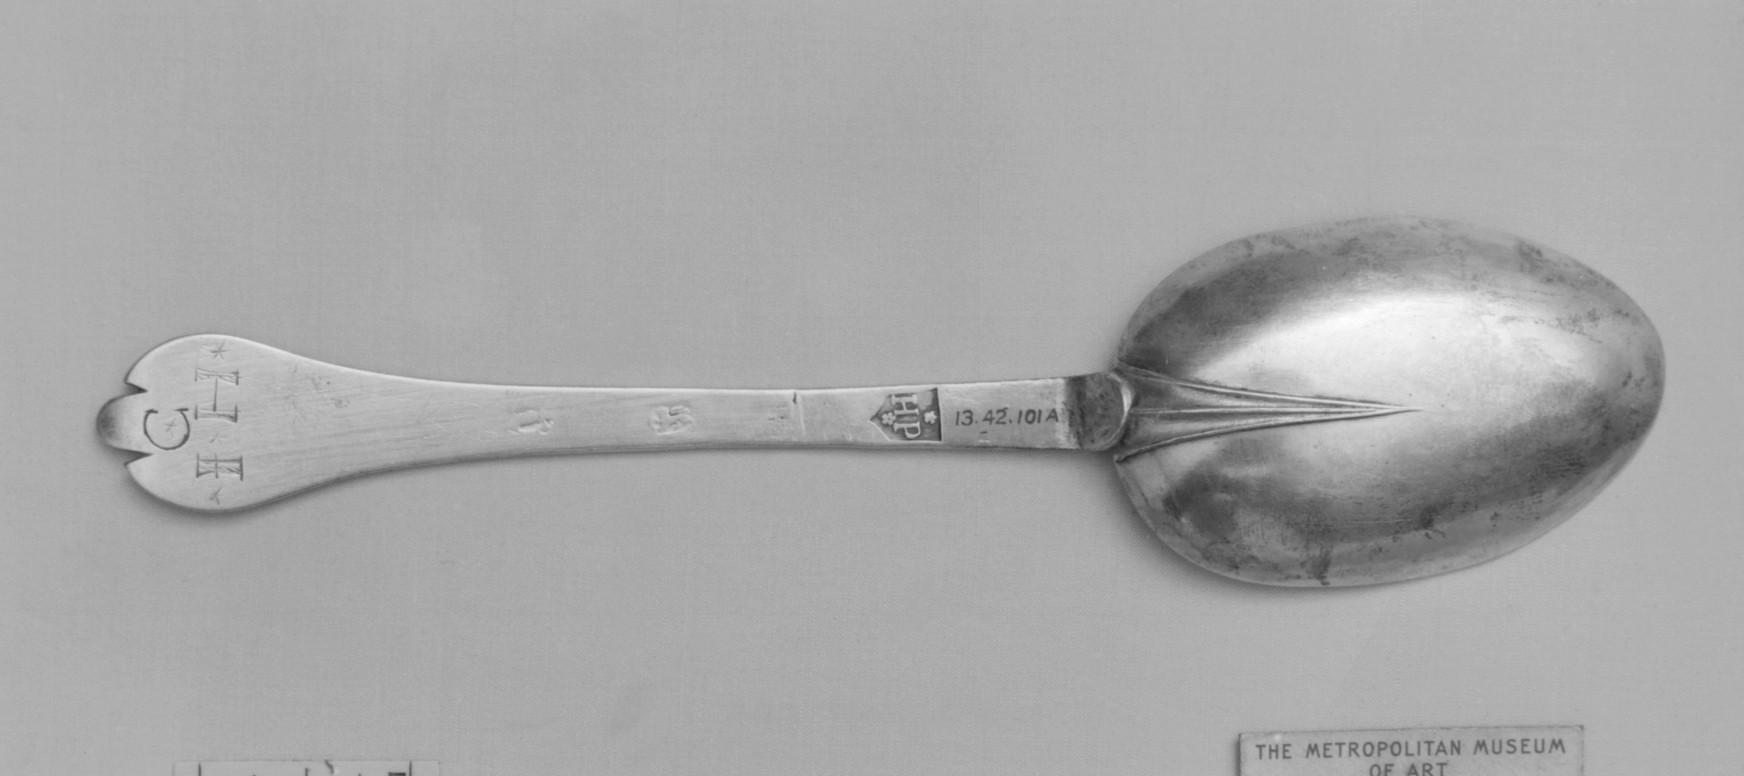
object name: spoon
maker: h. p., london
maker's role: maker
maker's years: 1693-1697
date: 1696-1697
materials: silver